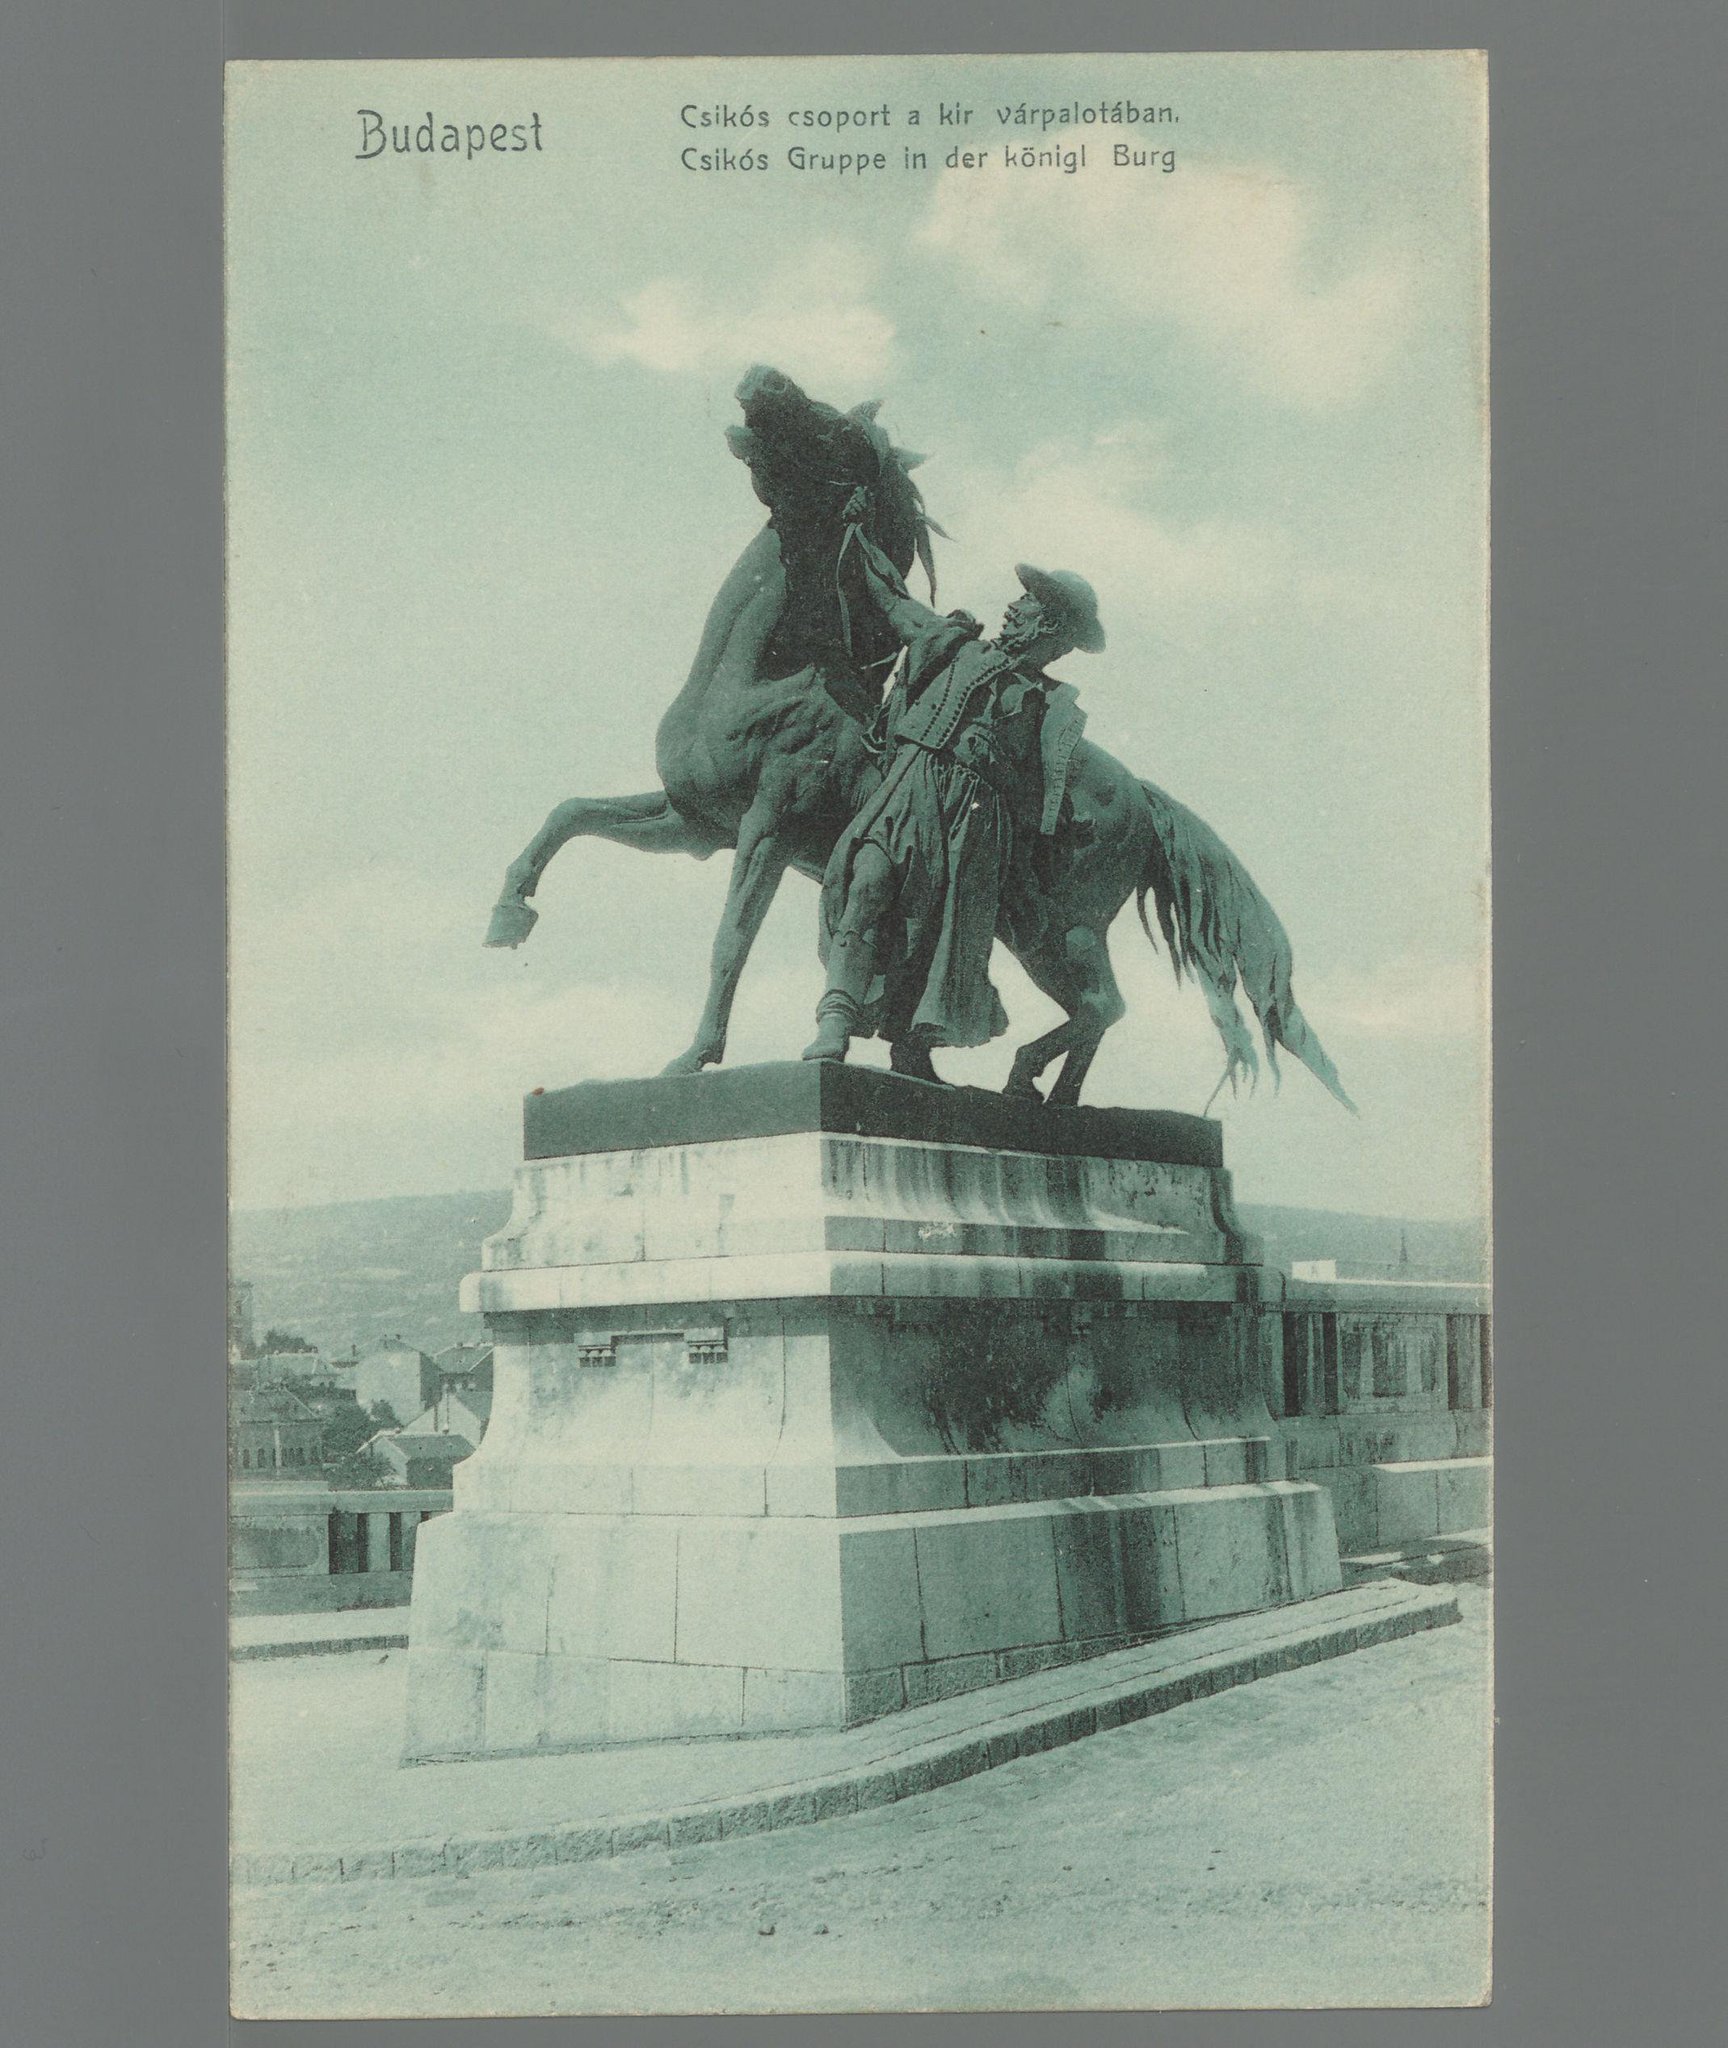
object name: photomechanical print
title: Budapest. Csikós csoport a kir várpalotában / Csikós Gruppe in der königl Burg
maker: Anonymous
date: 1906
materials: cardboard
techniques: photograph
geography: vienna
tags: castle, monument, statue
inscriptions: date